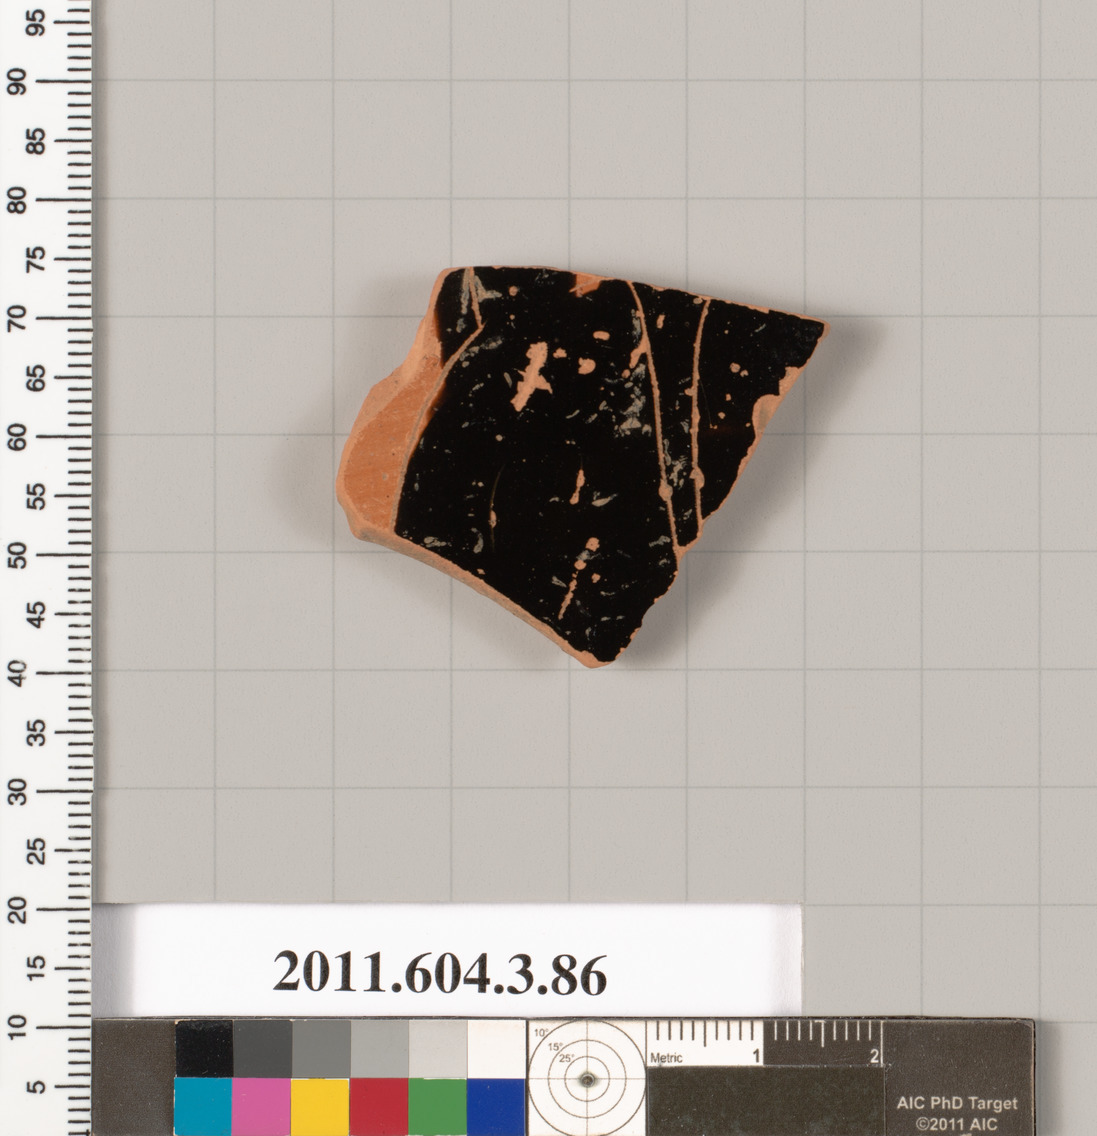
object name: amphora fragment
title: Terracotta fragment of an amphora (jar)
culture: greek, attic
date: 534-501 BCE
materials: terracotta